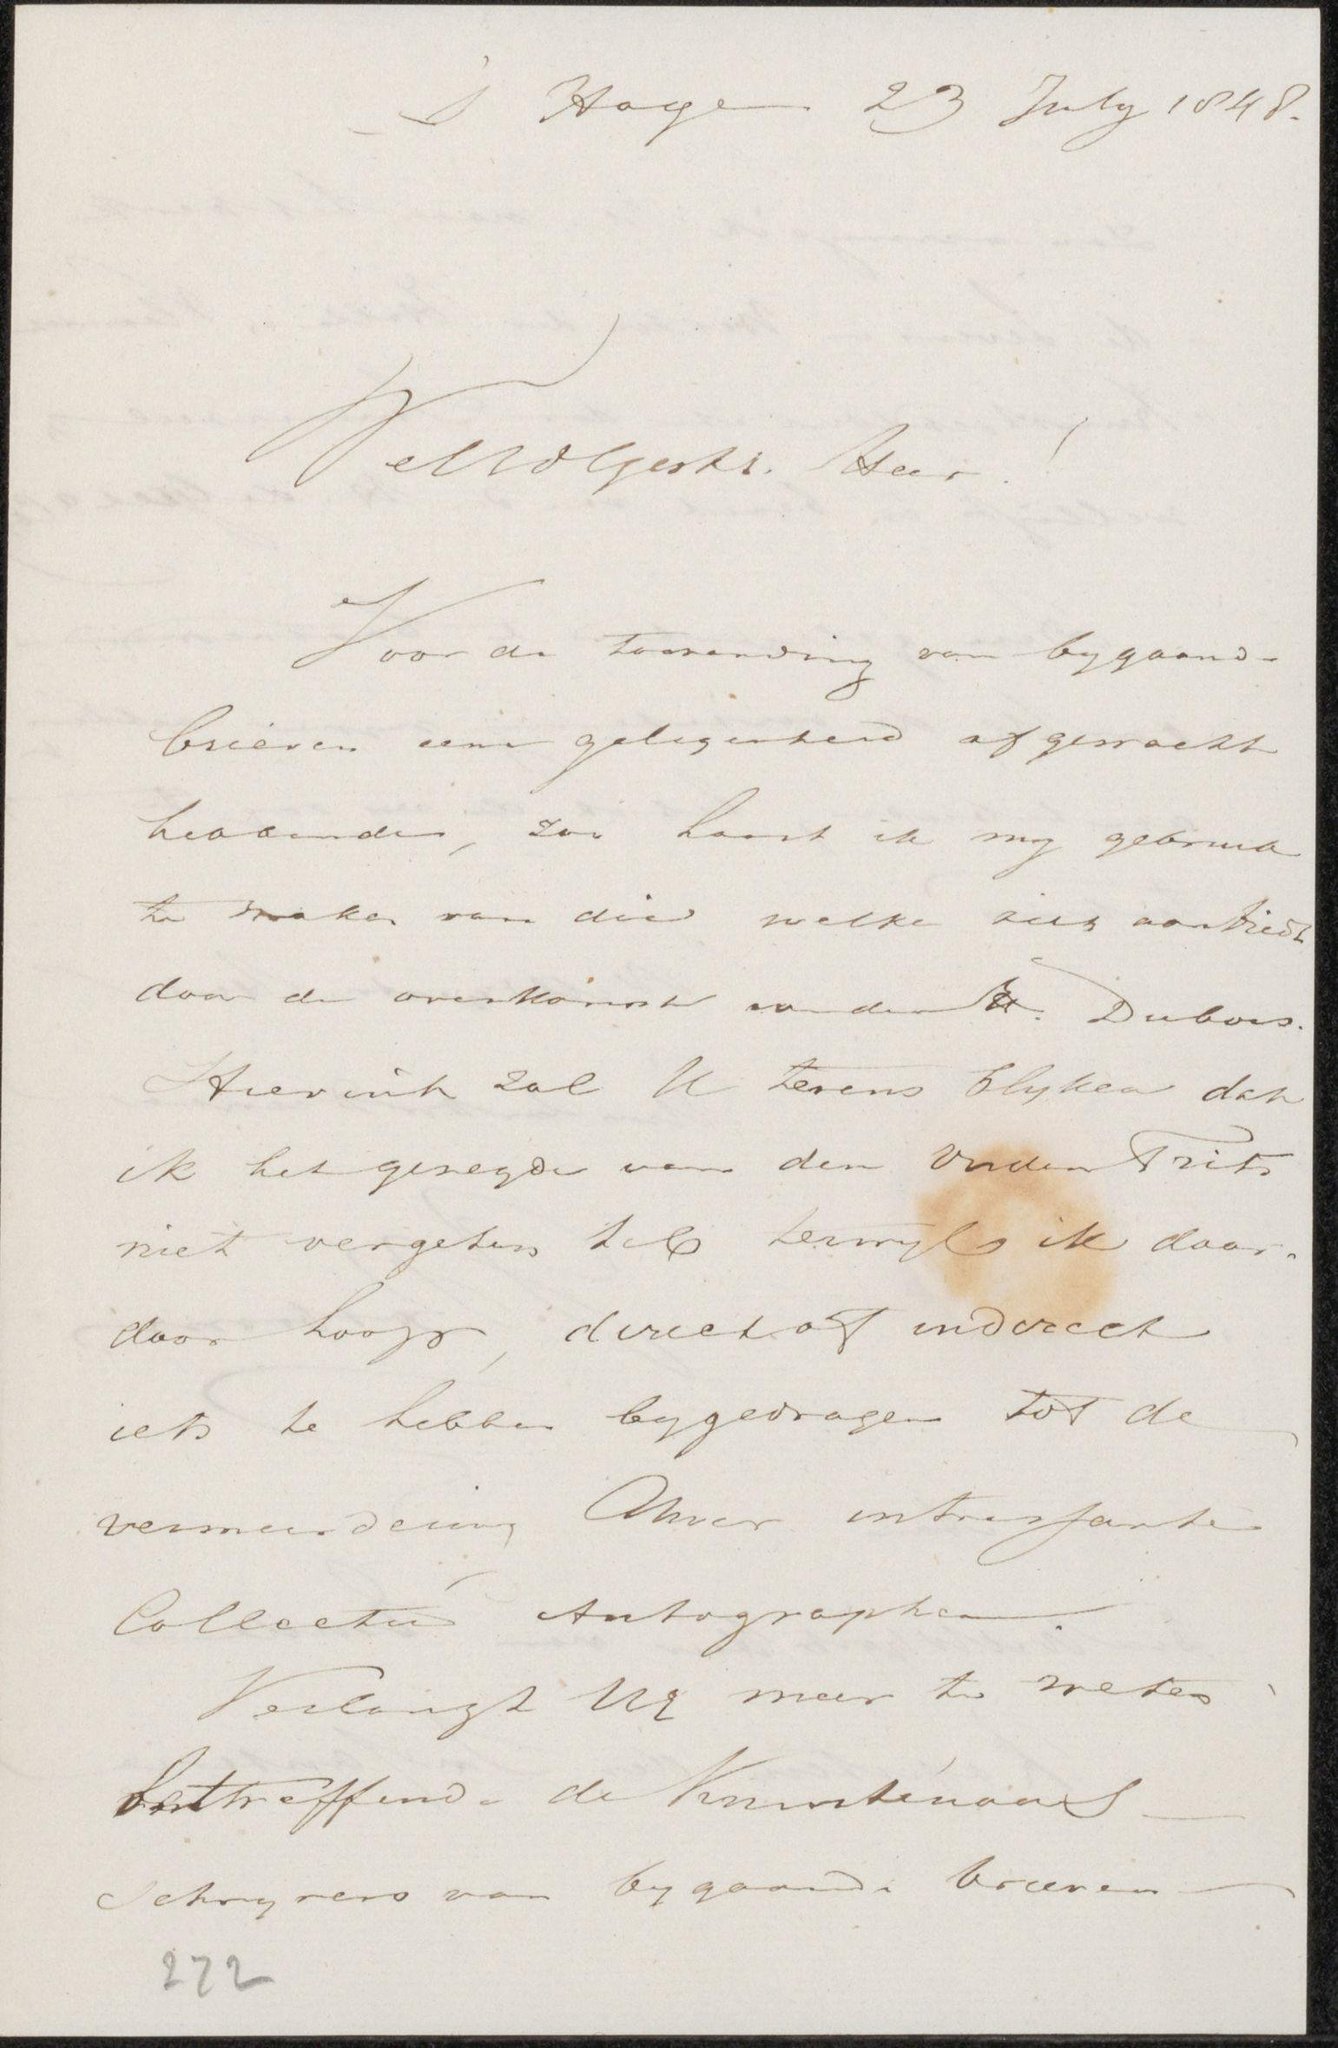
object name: letter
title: Brief aan de heer Van Emden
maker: johannes bosboom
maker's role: draughtsman, painter, print maker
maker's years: 1817-1891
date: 1848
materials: ink, paper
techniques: pen, writing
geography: the hague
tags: de heer van emden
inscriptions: seal